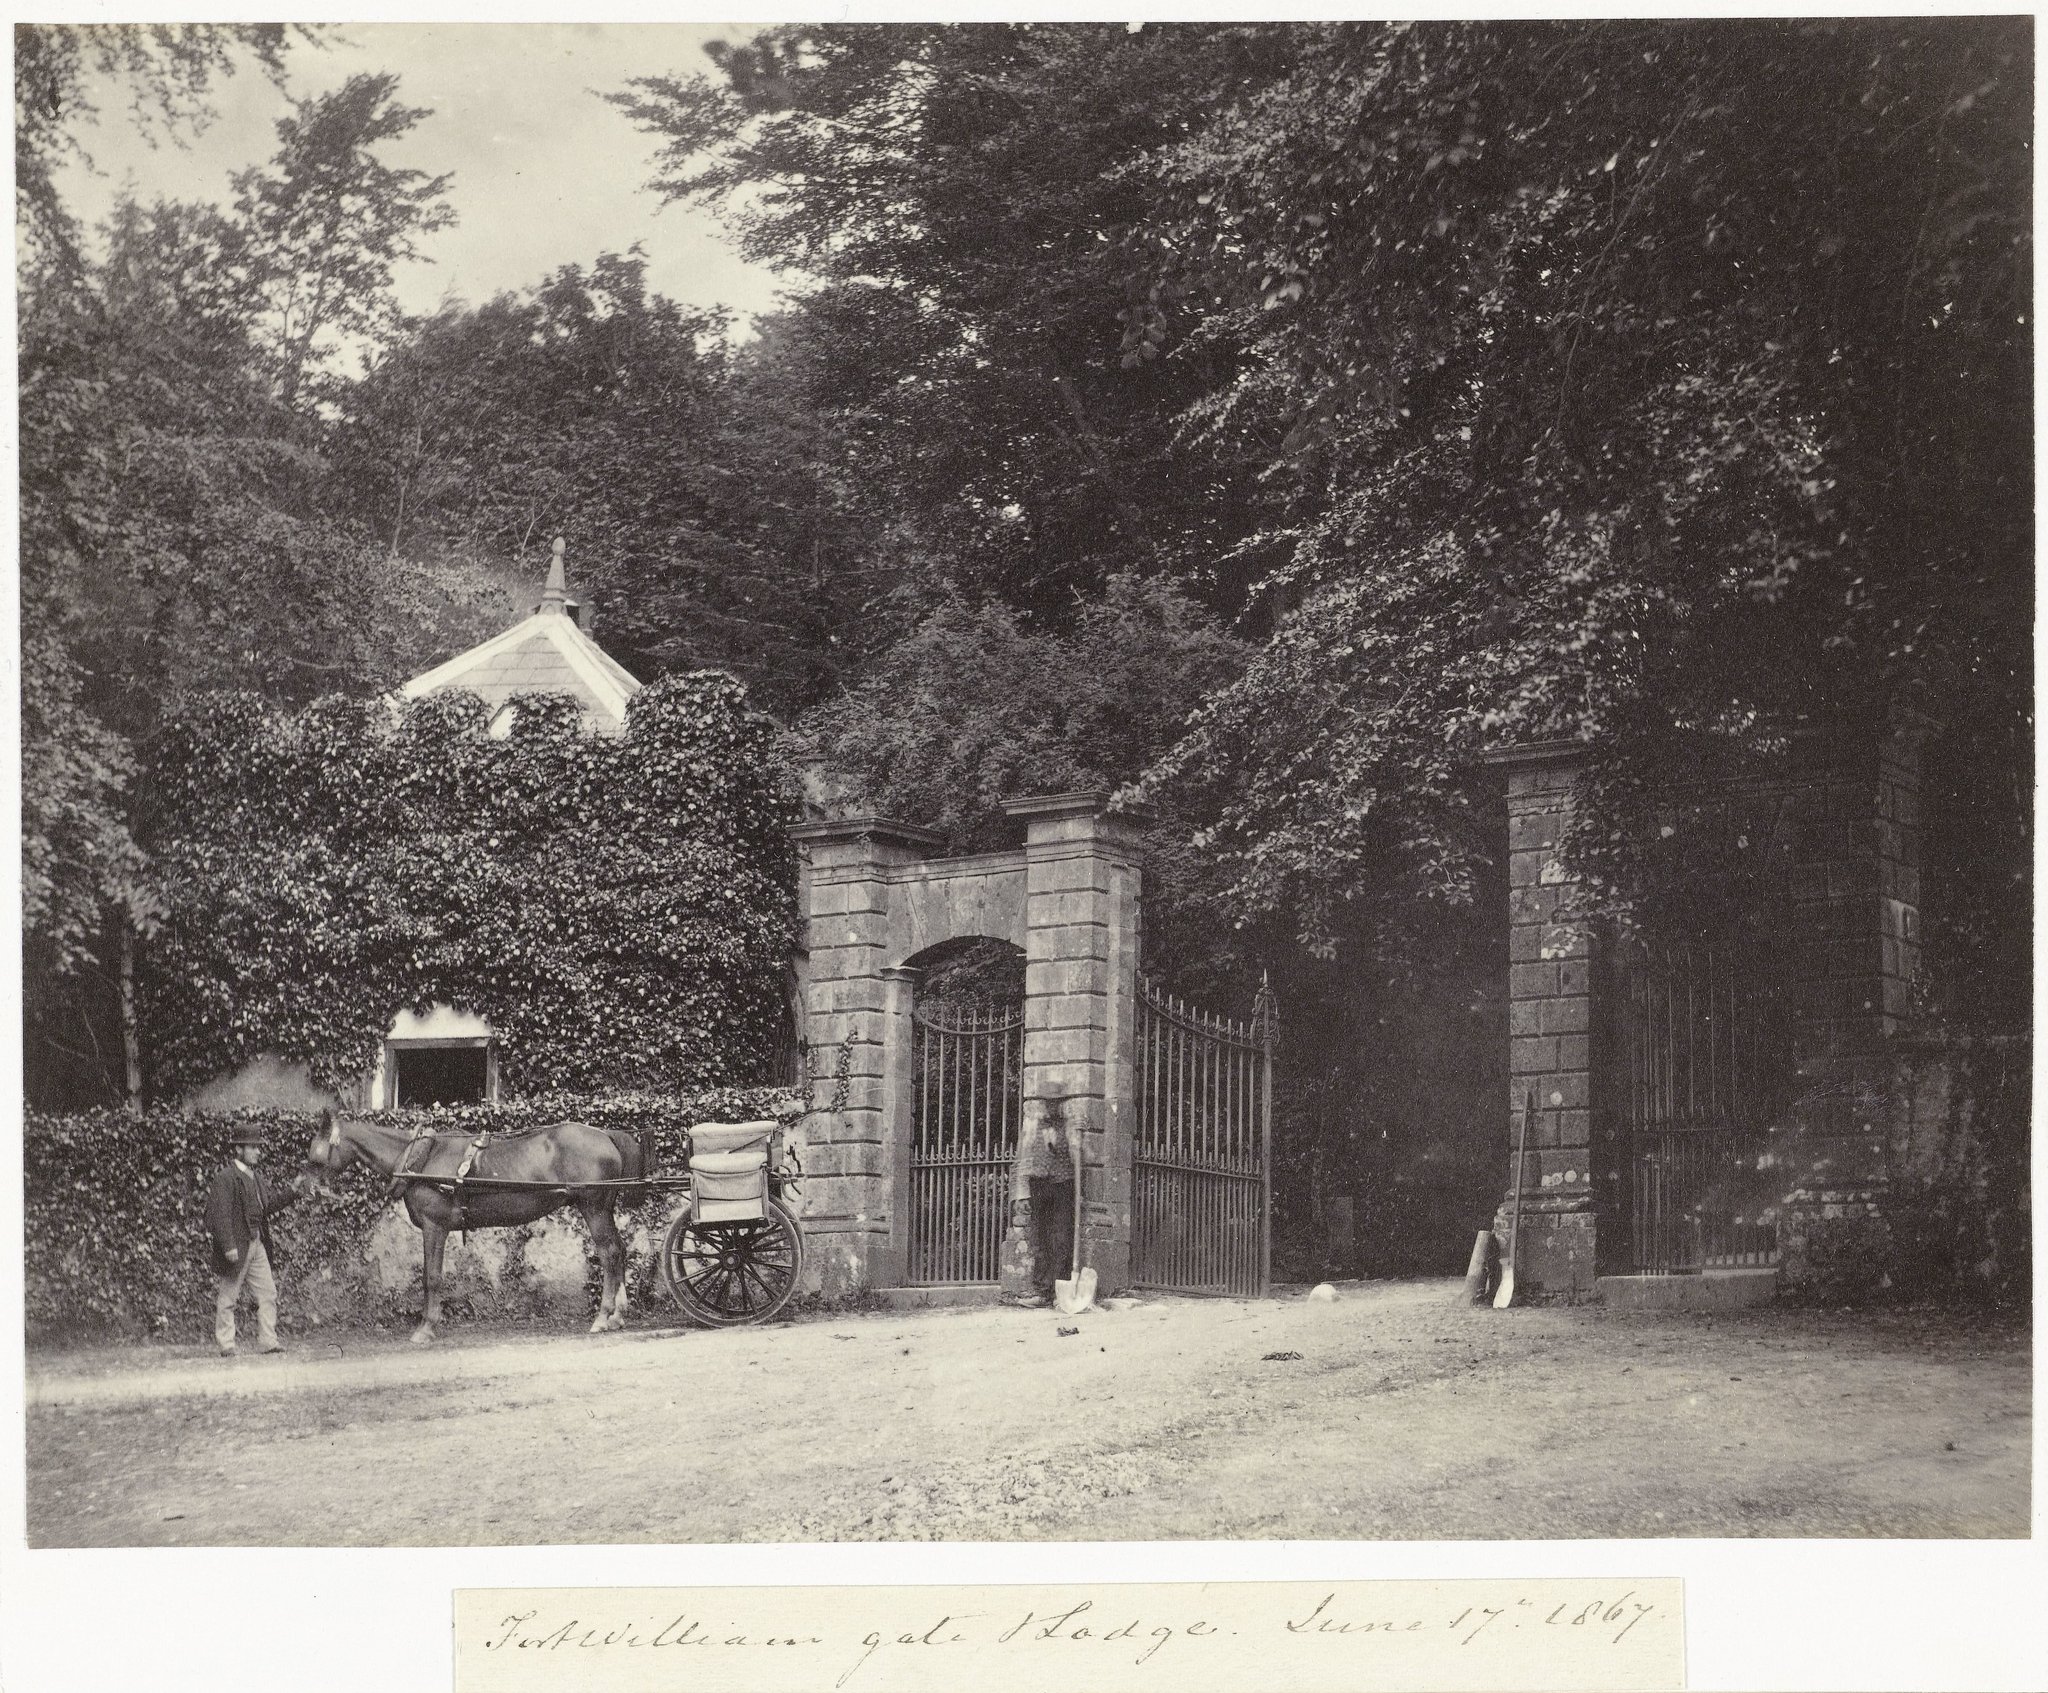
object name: photograph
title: Toegangshek van een landhuis in Fort William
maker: francis edmond currey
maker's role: fotograaf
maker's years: 1814-1896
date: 1867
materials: cardboard, paper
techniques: albumen print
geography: fortwilliam house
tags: gate, entrance